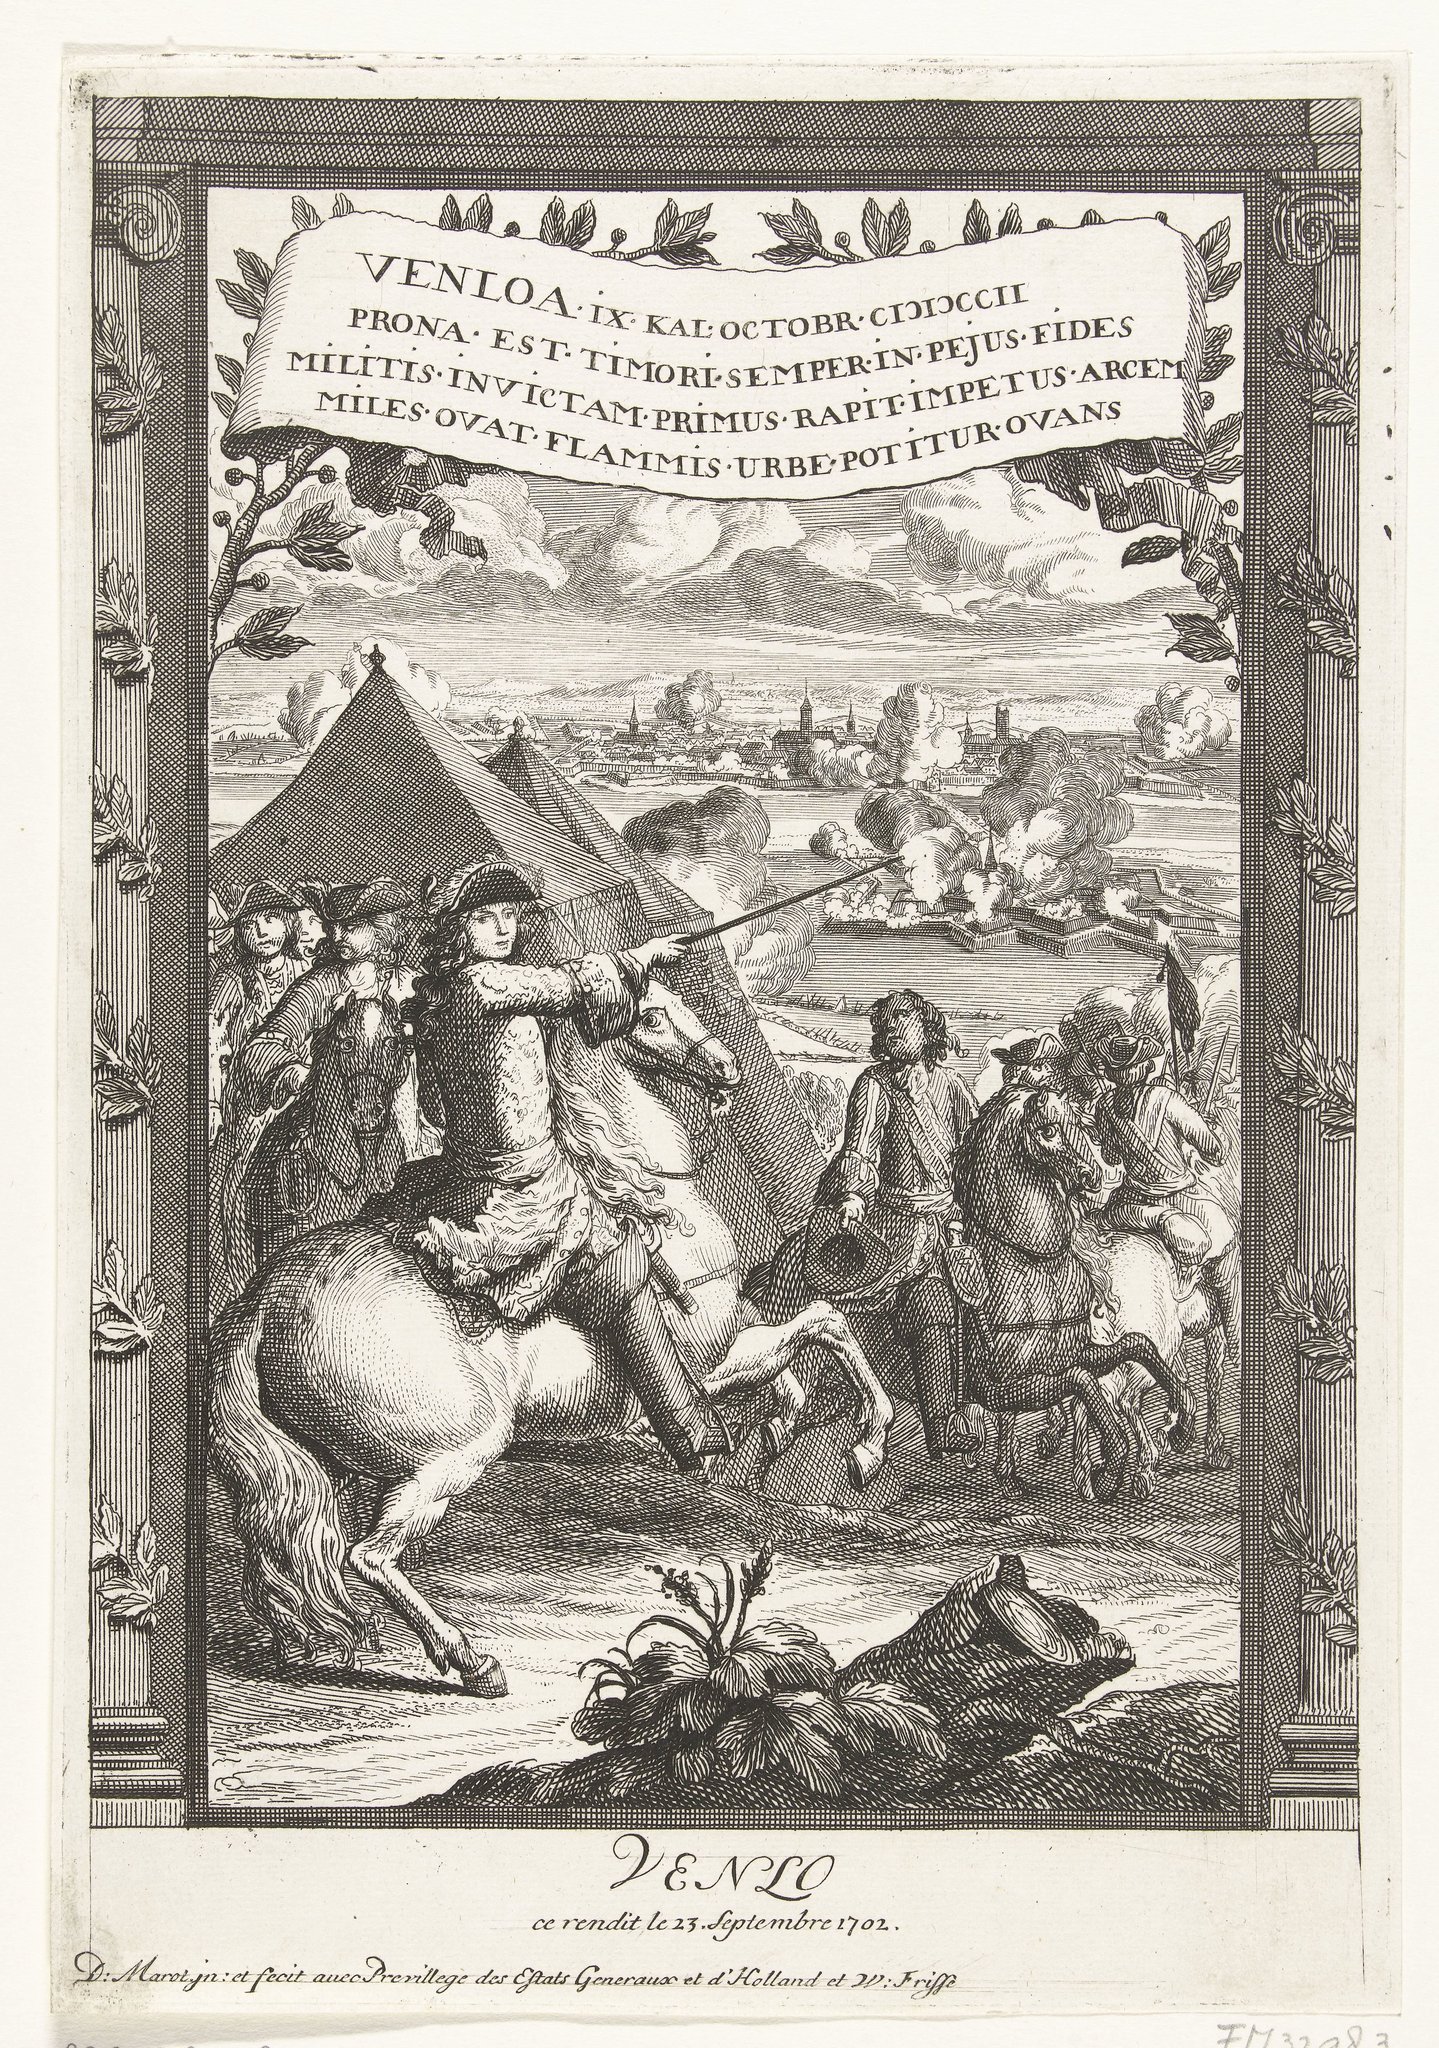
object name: print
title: Paneel met de overwinning te Venlo, 1702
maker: daniël marot (i)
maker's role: draughtsman, print maker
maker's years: 1661-1752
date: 1702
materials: paper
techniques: etching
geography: northern netherlands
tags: capture of city (after the siege)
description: Paneel met een voorstelling van de overwinningen te Venlo op 23 september 1702. Onderdeel van de decoraties op de stellage met de Tempel van Mars tijdens het vuurwerk op de Hofvijver op 13 december 1702 te Den Haag. De Tempel van Mars was versierd met acht panelen met voorstellingen van overwinningen van de geallieerden op Frankrijk en Spanje in het jaar 1702.